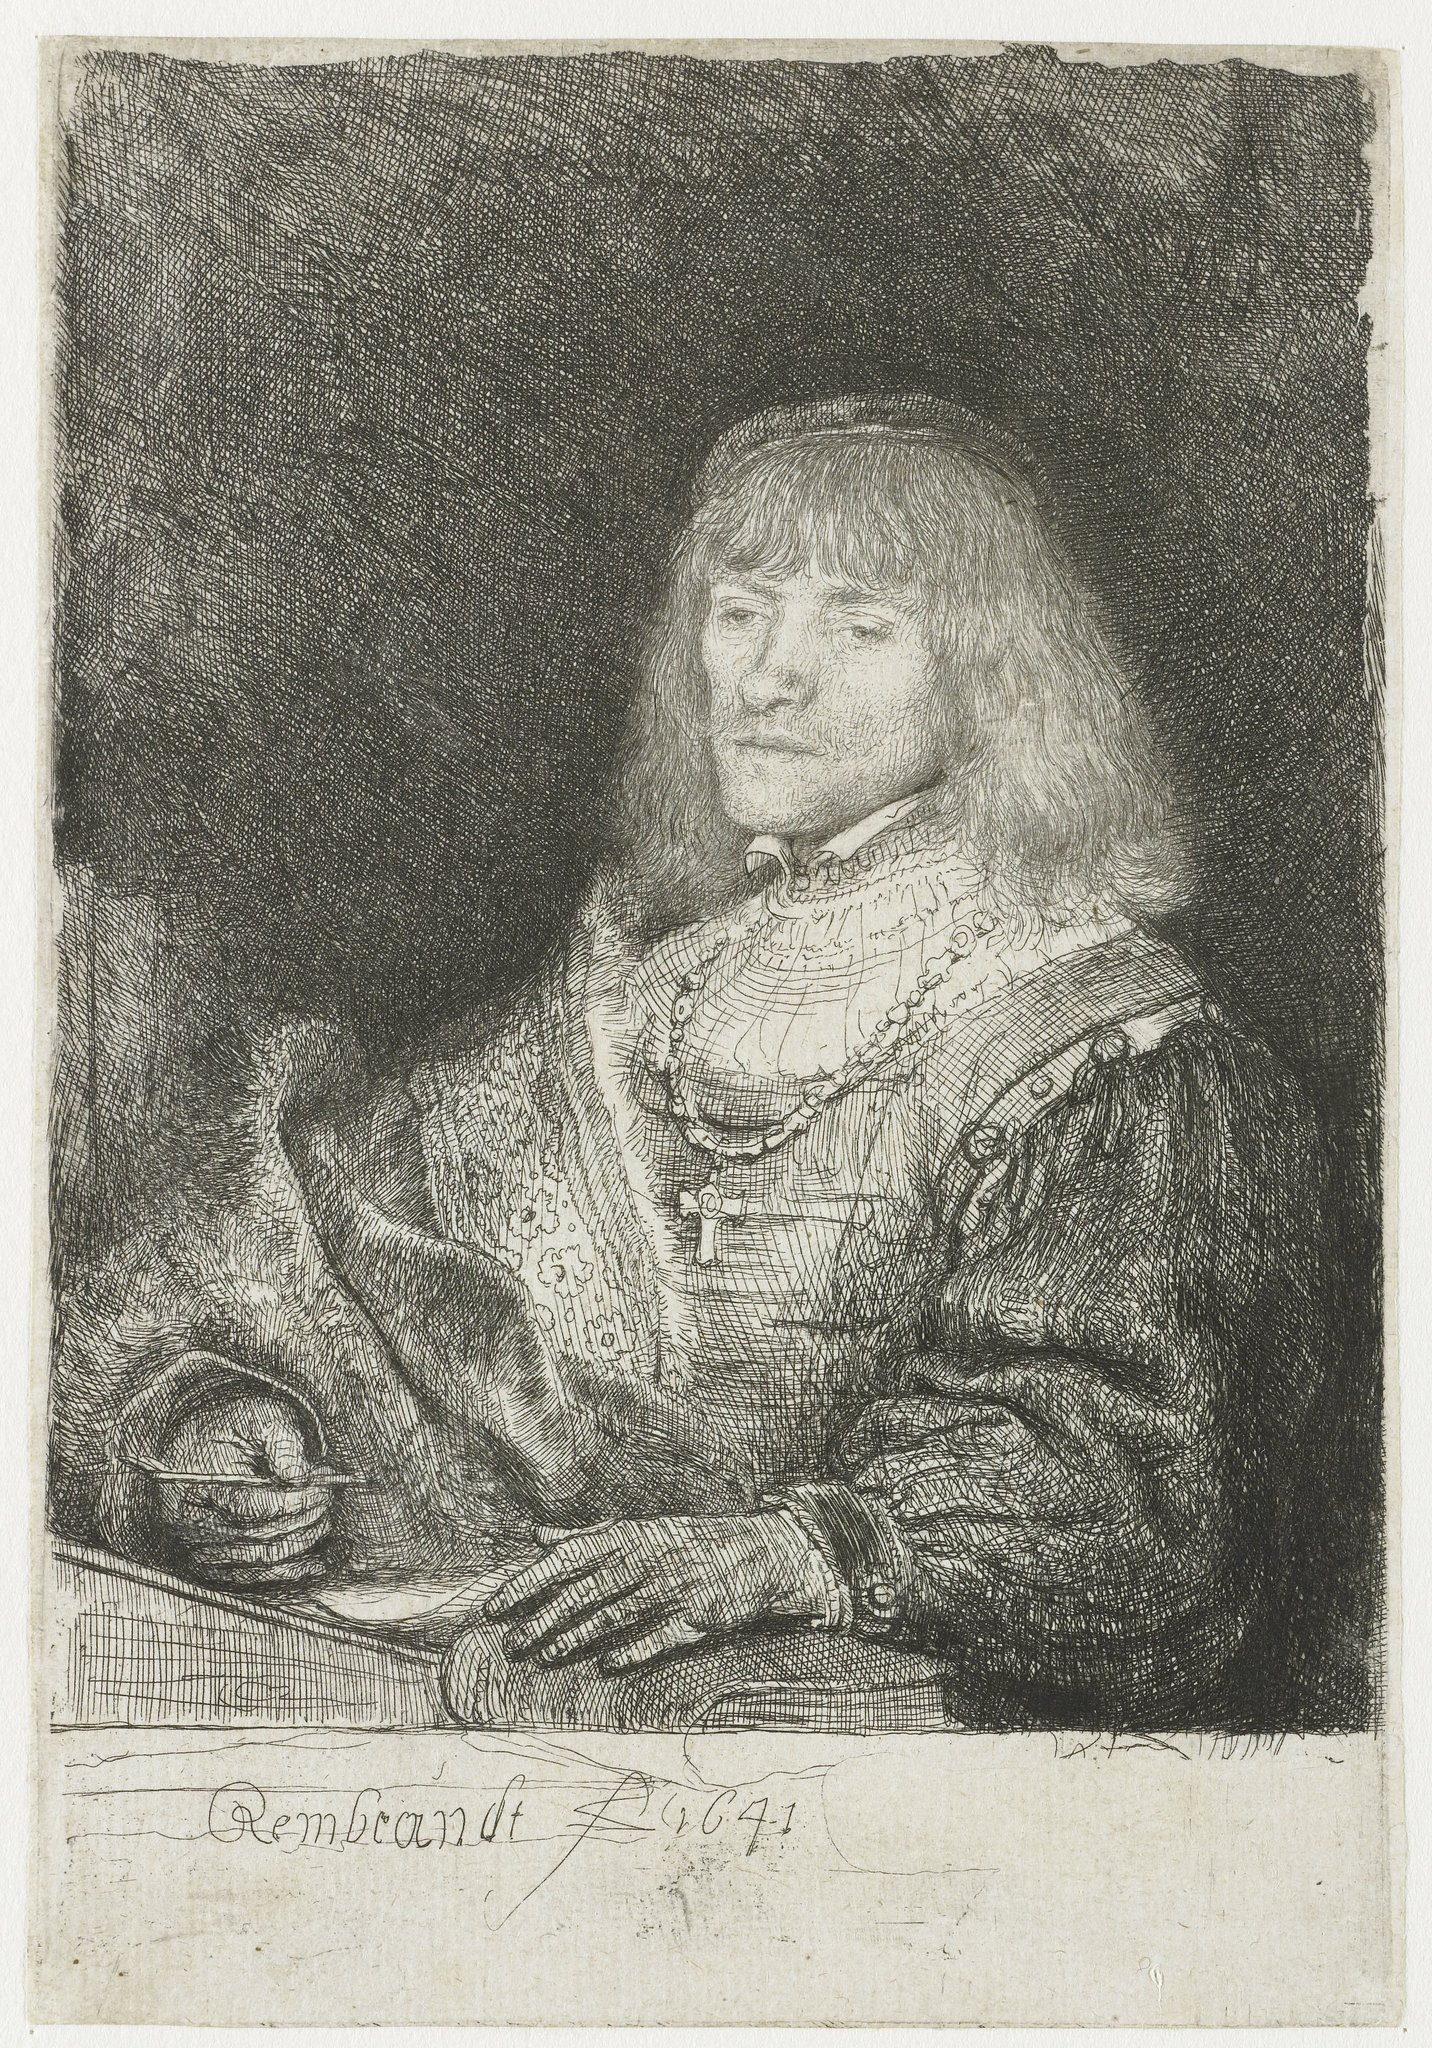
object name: print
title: Man at a desk wearing a cross and chain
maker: rembrandt van rijn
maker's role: draughtsman, painter, print maker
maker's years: 1606-1669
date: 1641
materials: paper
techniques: drypoint, etching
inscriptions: mark: Lugt 2228, mark: Lugt 1442, signature and date: ‘Rembrandt f 1641’, mark: Lugt 272, mark: Lugt 1021, mark: Lugt 652 a, mark: Lugt 58